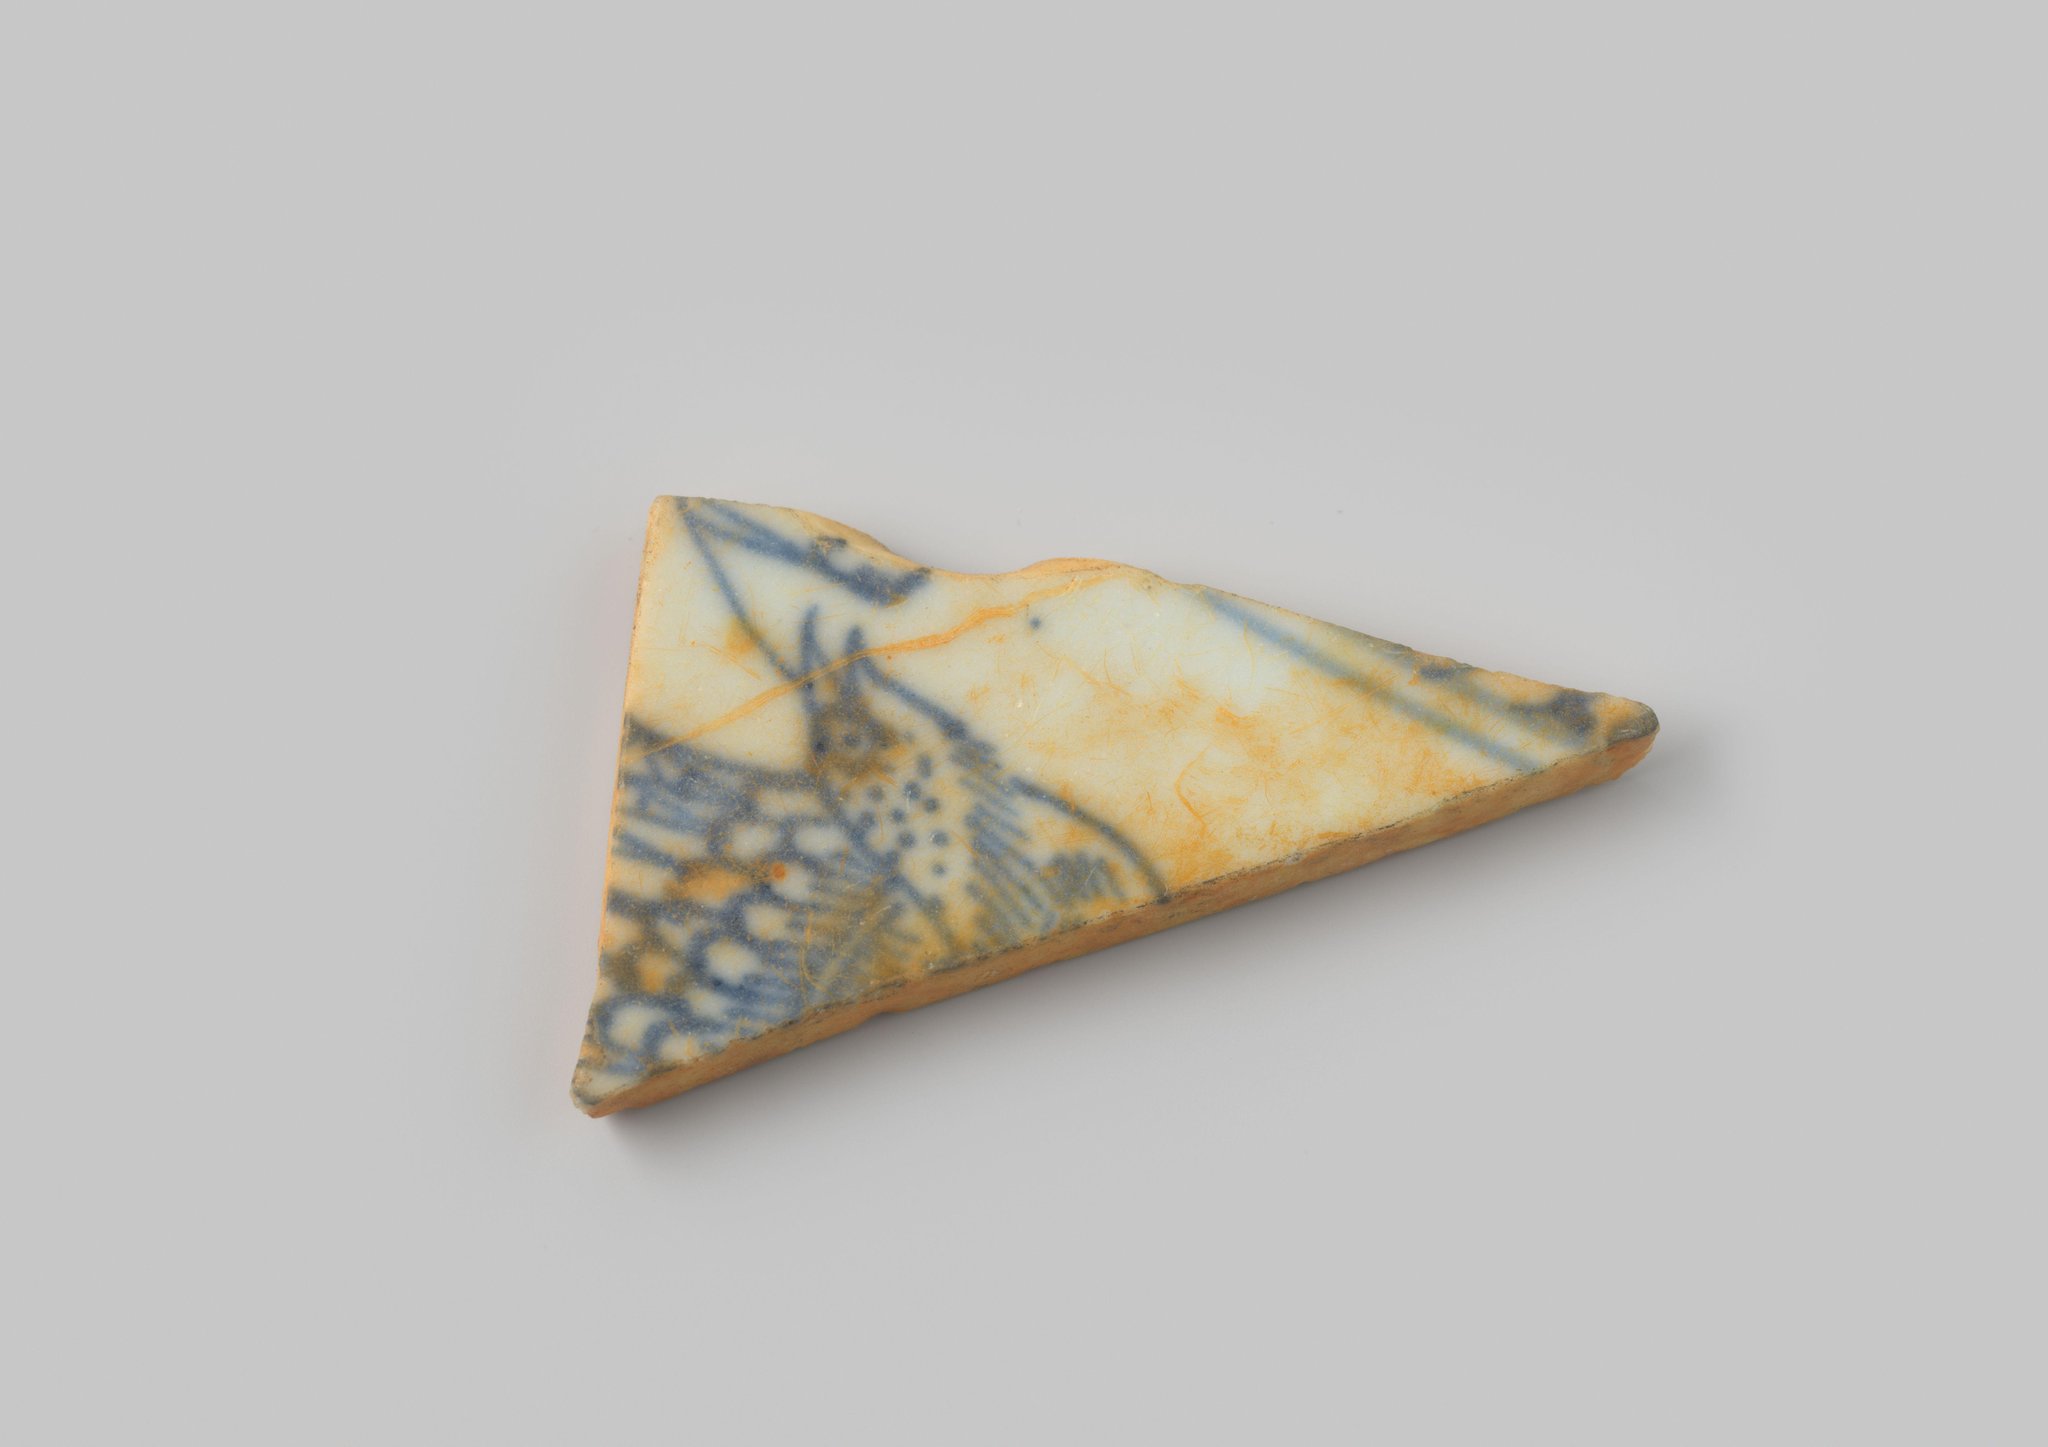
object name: plate dish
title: Scherf van een bord uit het wrak van de Oost-Indiëvaarder Hollandia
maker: Anonymous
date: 1700-1743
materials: porcelain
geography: netherlands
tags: verenigde oostindische compagnie, hollandia (schip), annet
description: Porcelain, plate, type 1; fragm of rim, sim. NG 1980-27H1662.